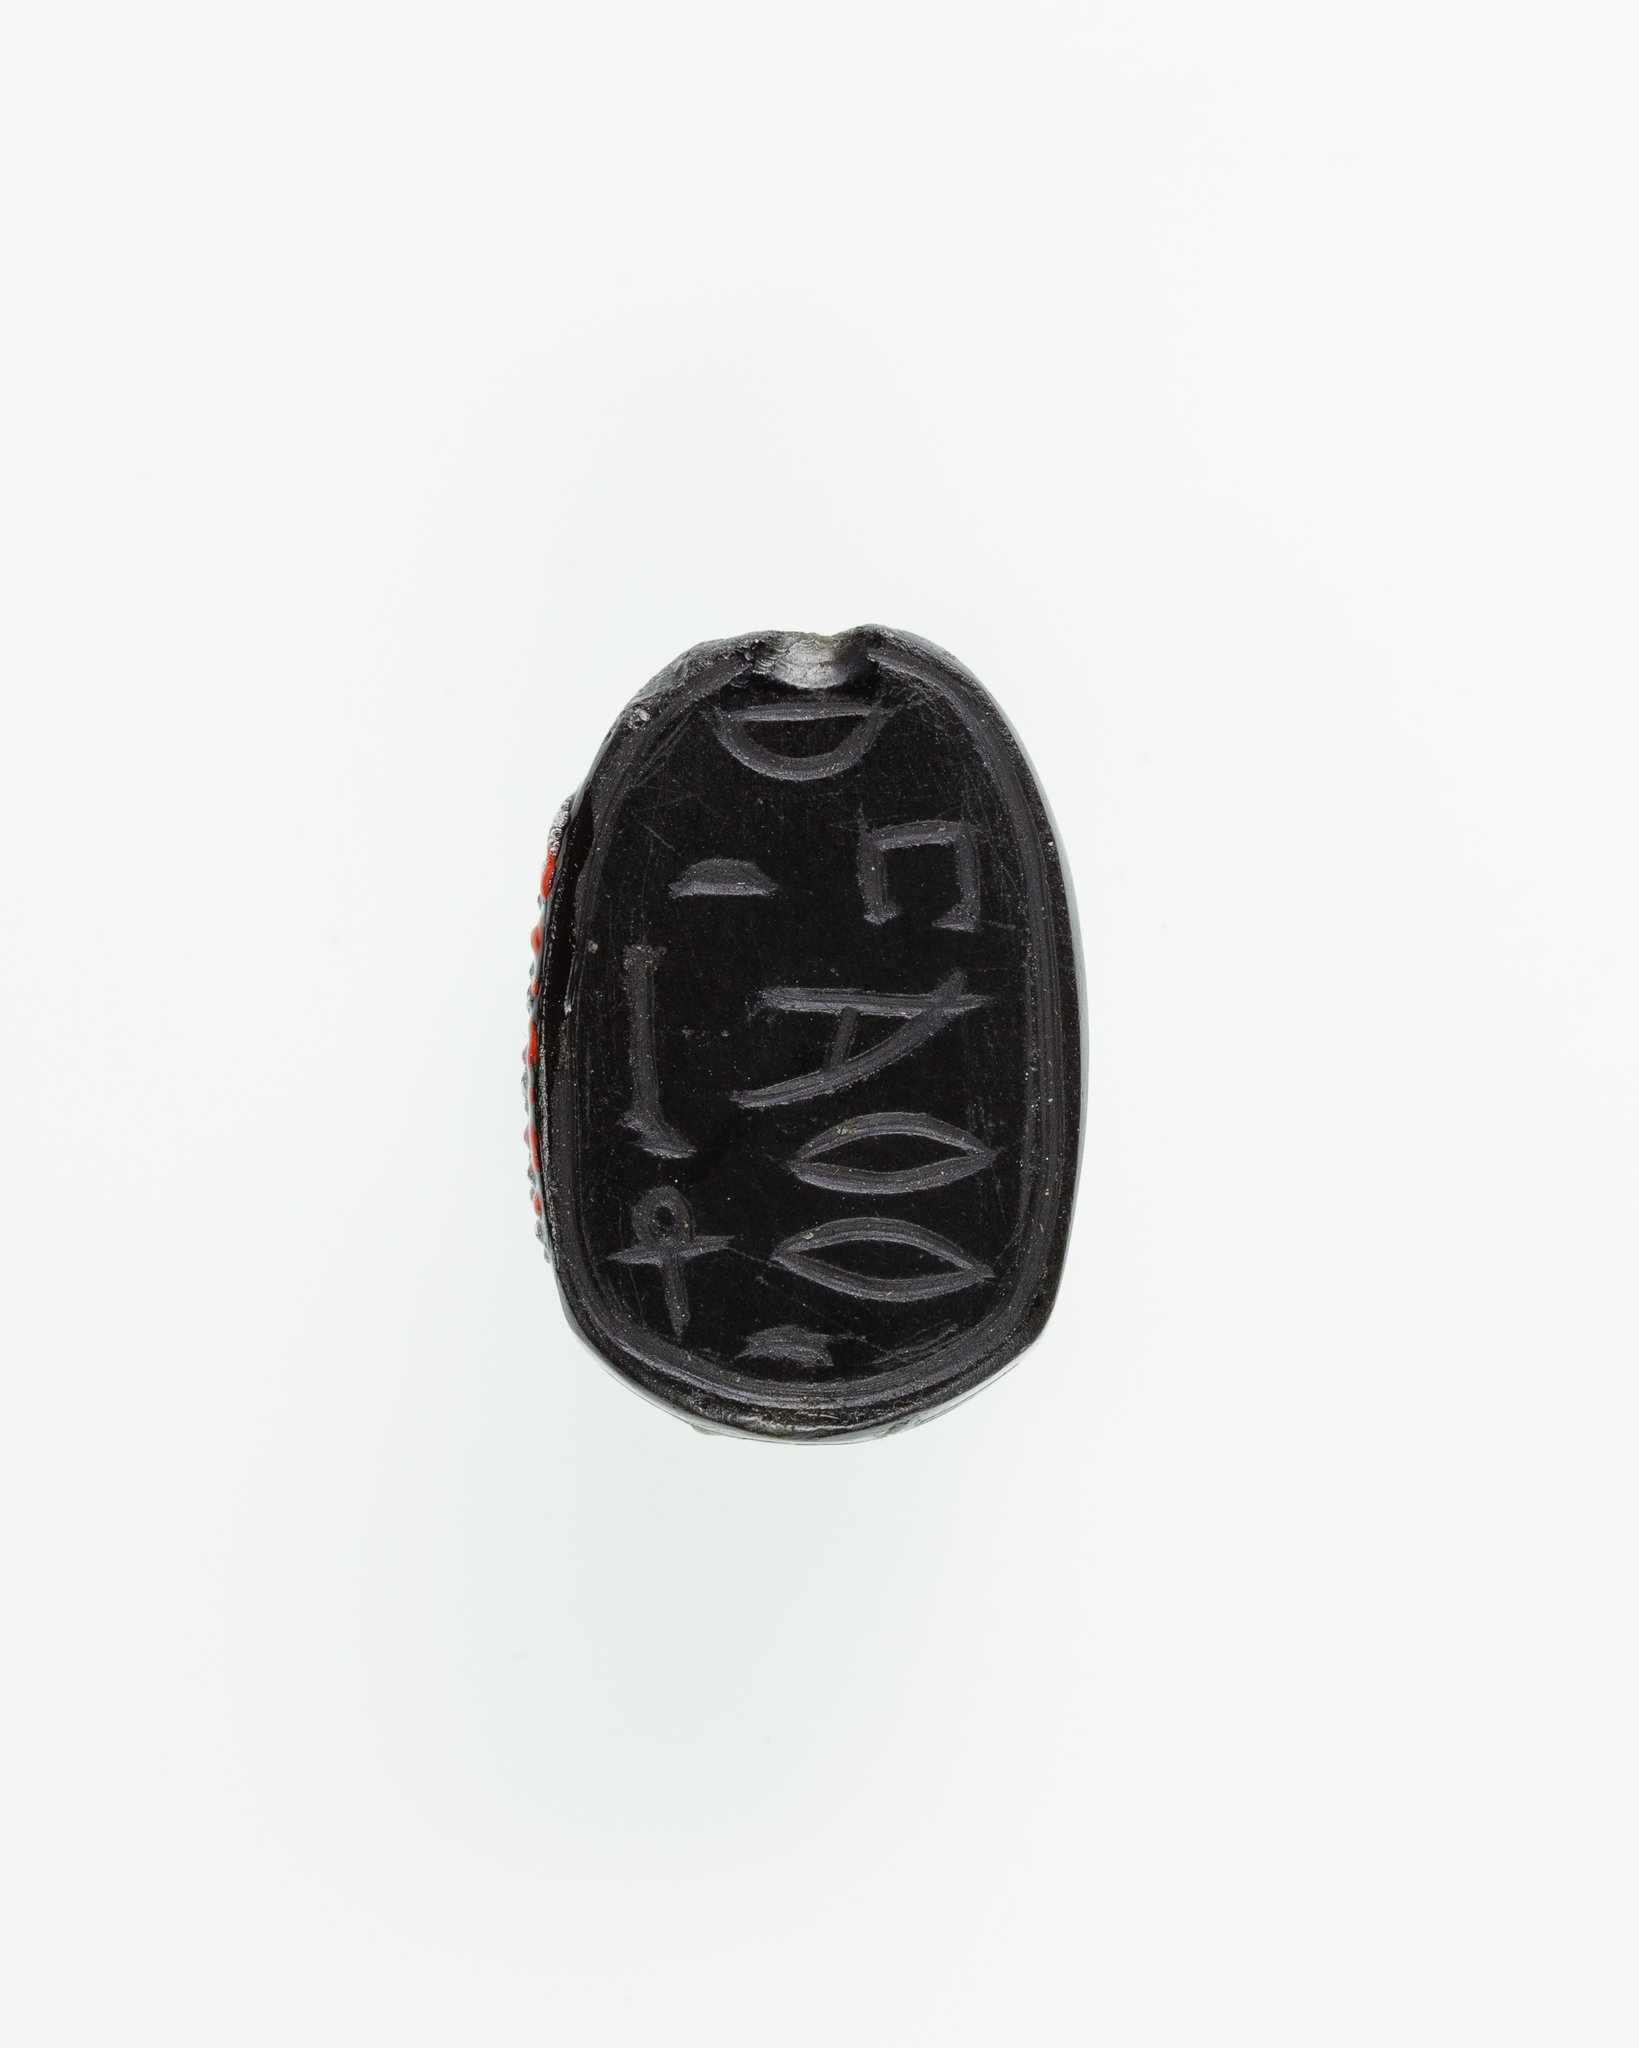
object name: scarab, private name and title, hieroglyph, housemistress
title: Scarab of the Lady Mereret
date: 1802-1640 BCE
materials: obsidian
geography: egypt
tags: hieroglyphs,scarabs